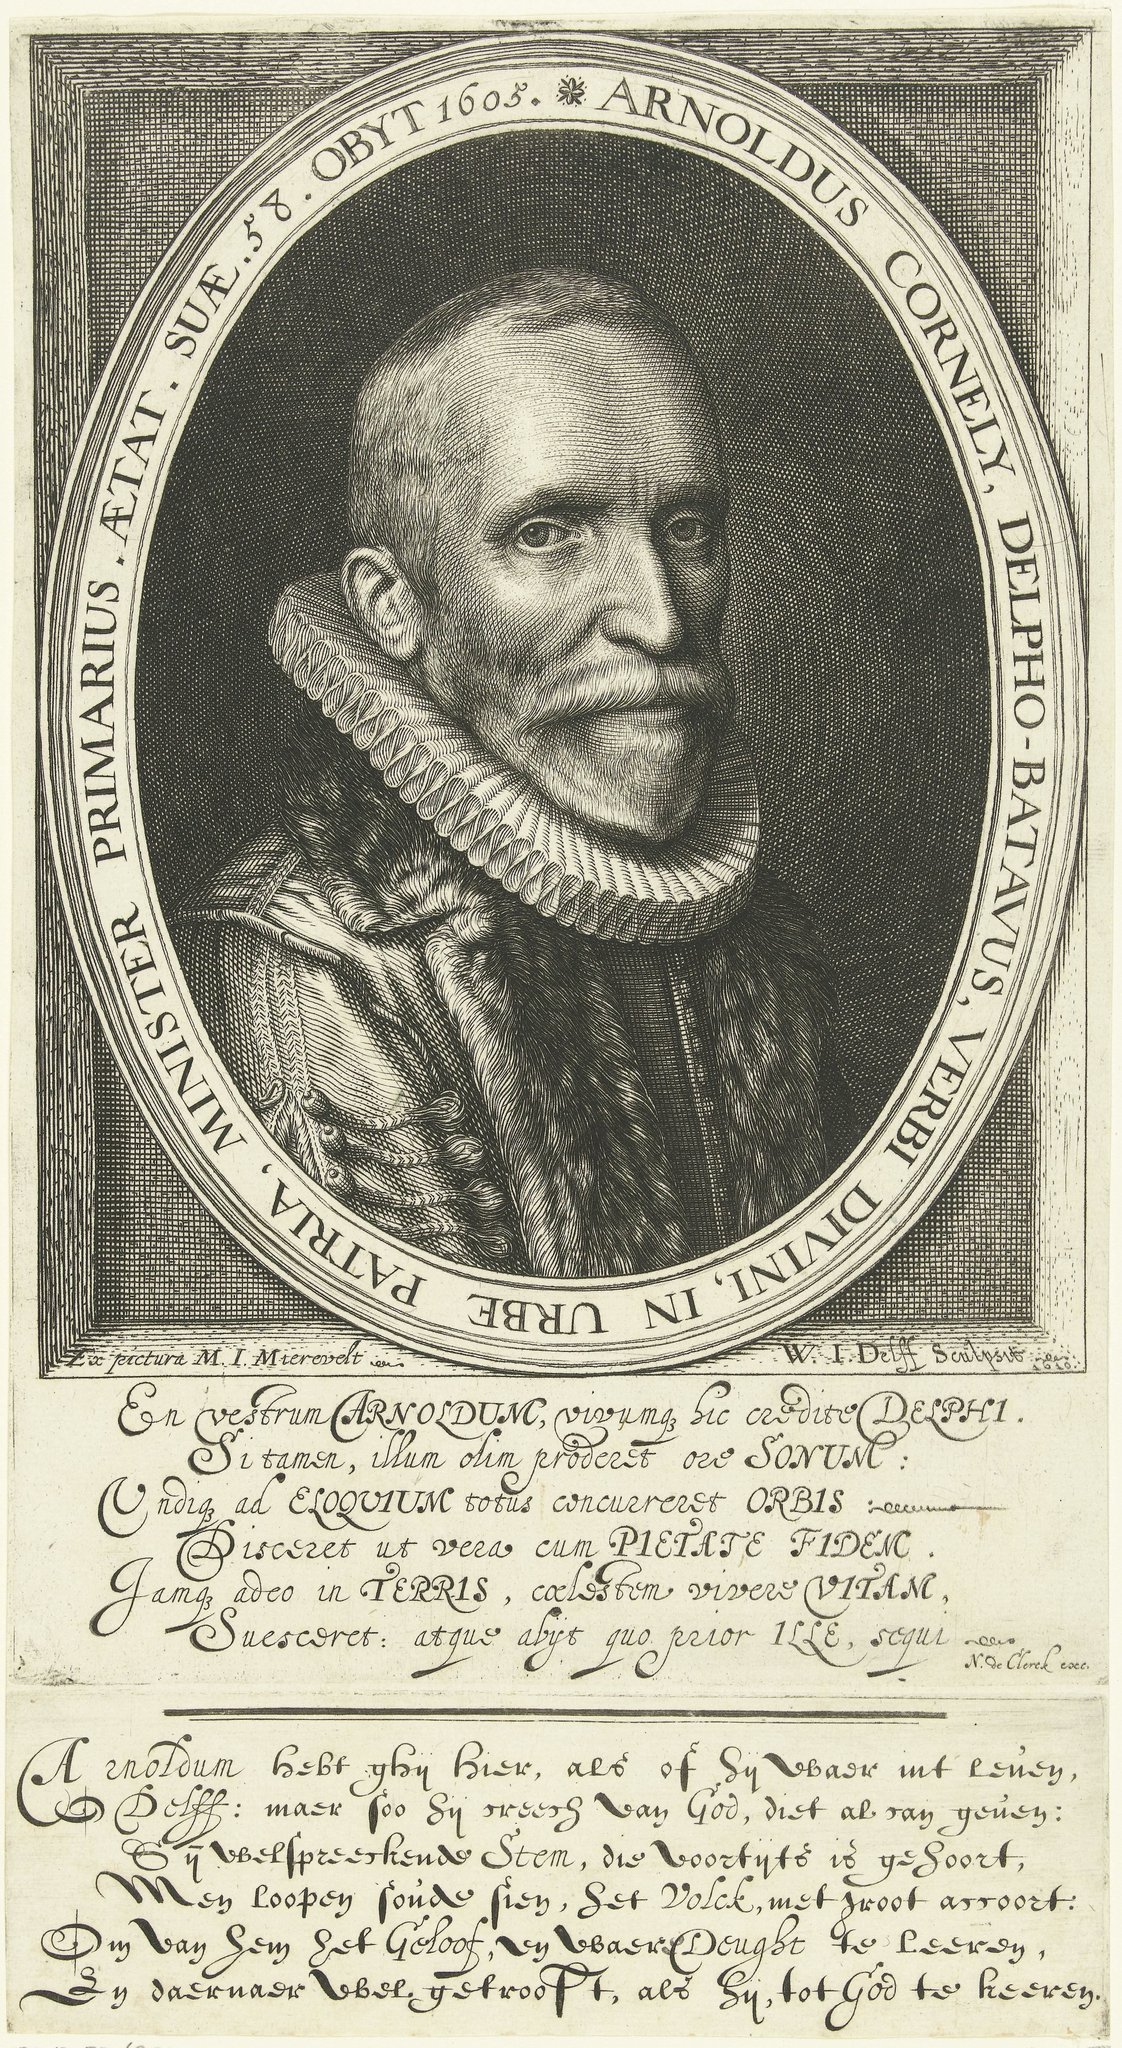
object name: print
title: Portret van predikant Arnold Cornelisz. Crusius op 58-jarige leeftijd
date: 1610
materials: paper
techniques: engraving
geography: delft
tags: delft, functionaries and dignitaries (with name) ~ episcopal protestant churches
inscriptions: collector's mark: Lugt 240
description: Portret van predikant Arnold Cornelisz. Crusius op 58-jarige leeftijd, borststuk met molenkraag en toga in ovale omlijsting met Latijns opschrift. In ondermarge twee lofdichten, in Latijns en Nederlands, in zes regels. Het Nederlandse vers gedrukt met een aparte plaat.